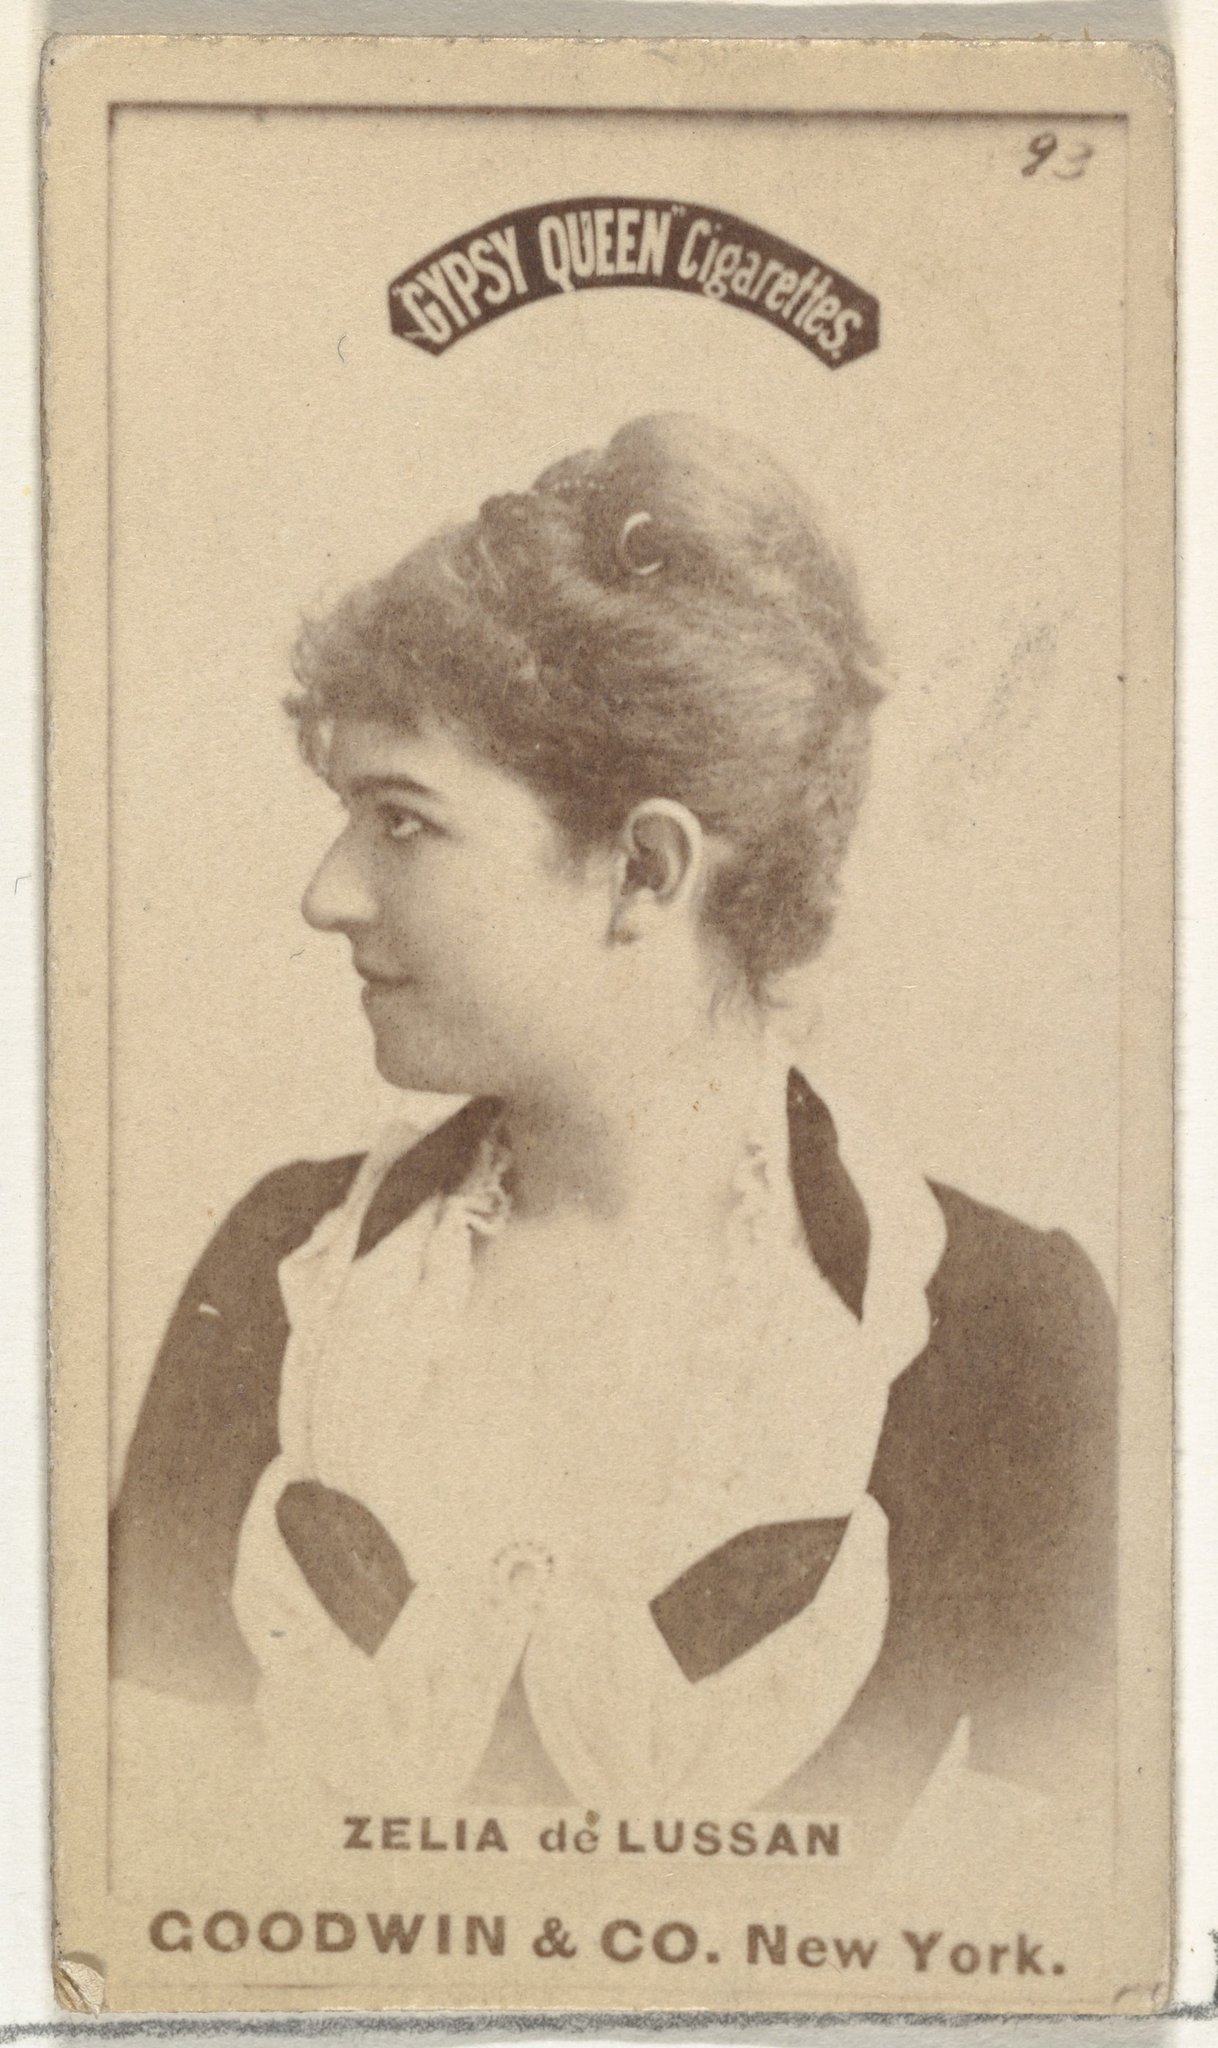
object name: photograph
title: Zelia de Lussan, from the Actors and Actresses series (N171) for Gypsy Queen Cigarettes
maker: goodwin & company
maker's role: publisher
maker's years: 1850-1950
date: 1886-1890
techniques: albumen silver print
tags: portraits,women,actresses